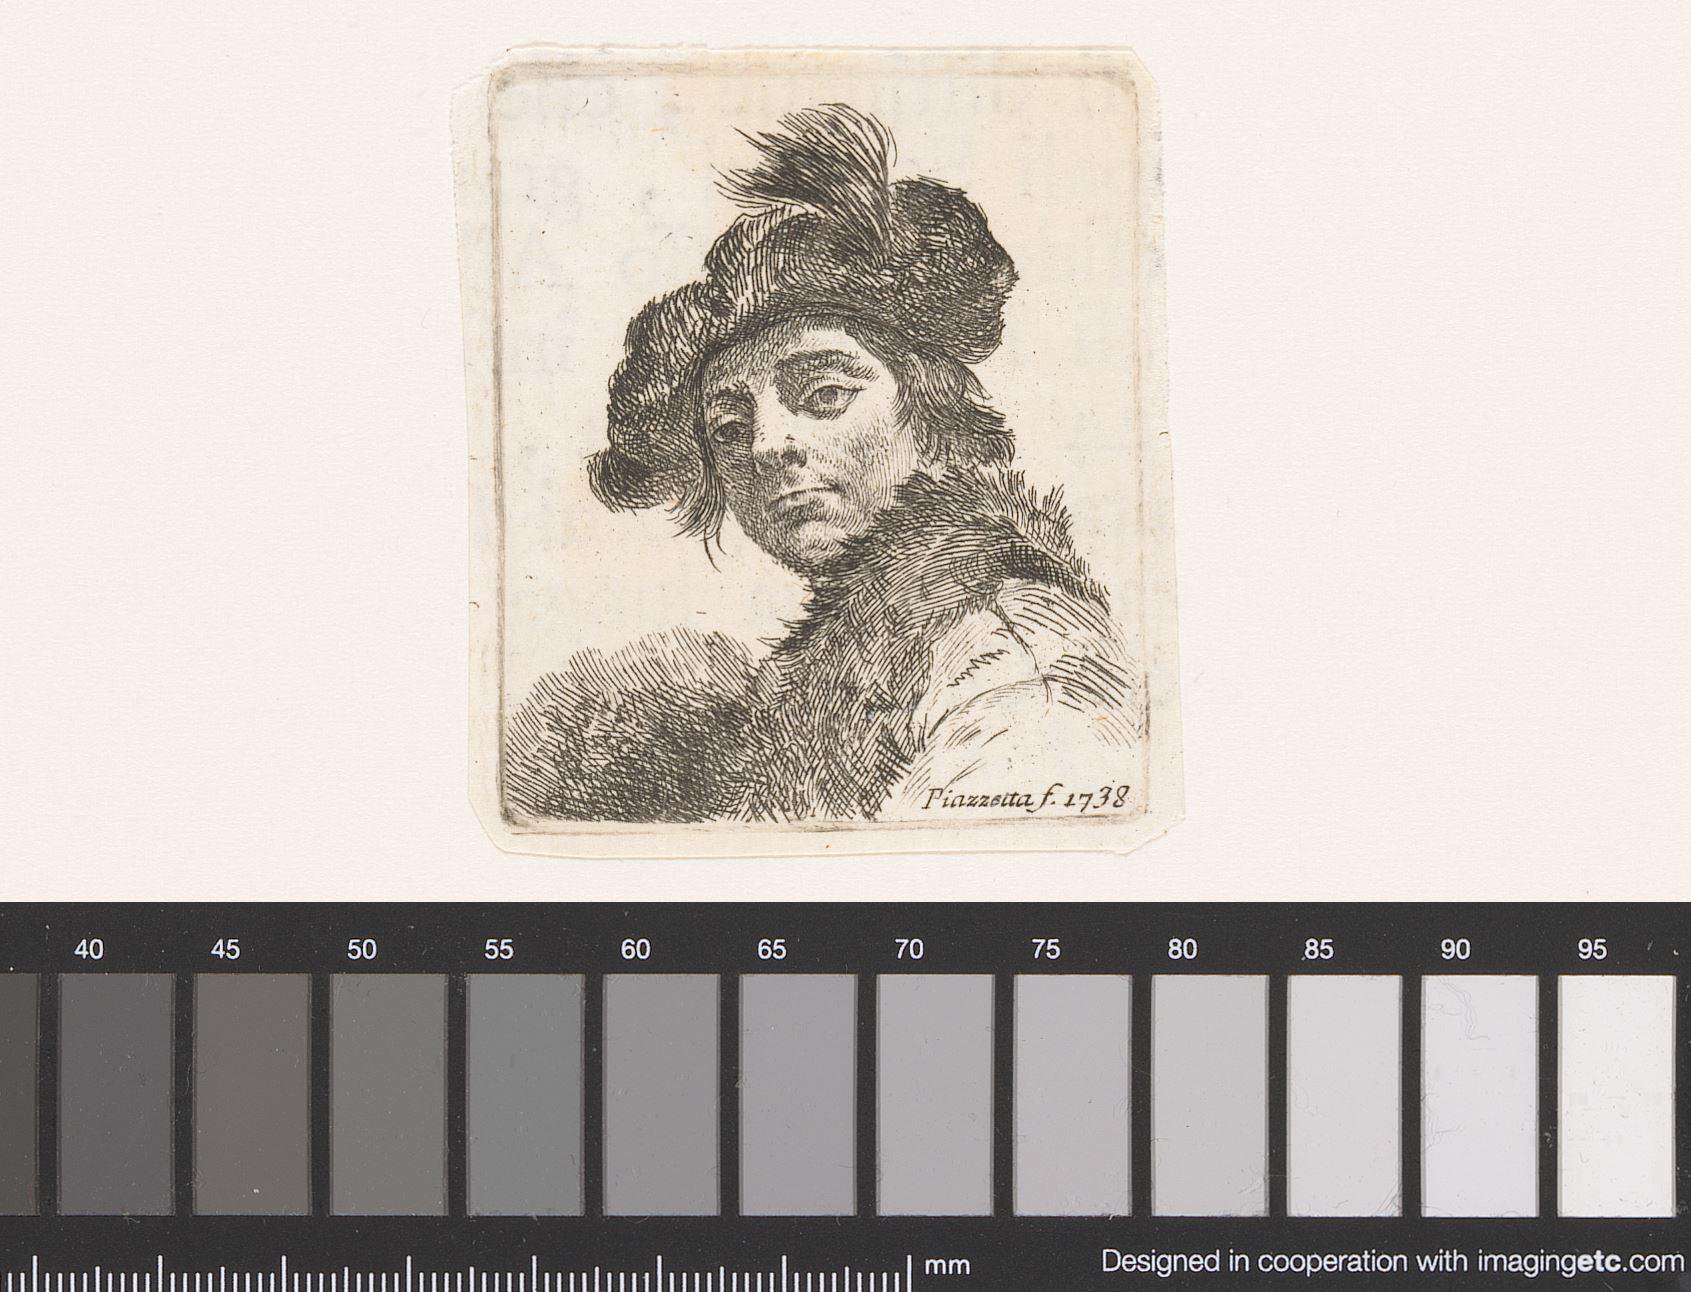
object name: print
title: Zelfportret van Giovanni Battista Piazzetta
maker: giovanni battista piazzetta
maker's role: draughtsman, painter, print maker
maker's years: 1682-1754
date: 1738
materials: paper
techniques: etching, letterpress printing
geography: italy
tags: venice, painter, draughtsman, giovanni battista piazzetta, historical persons, portrait, self-portrait of artist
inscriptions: collector's mark: Lugt 2228